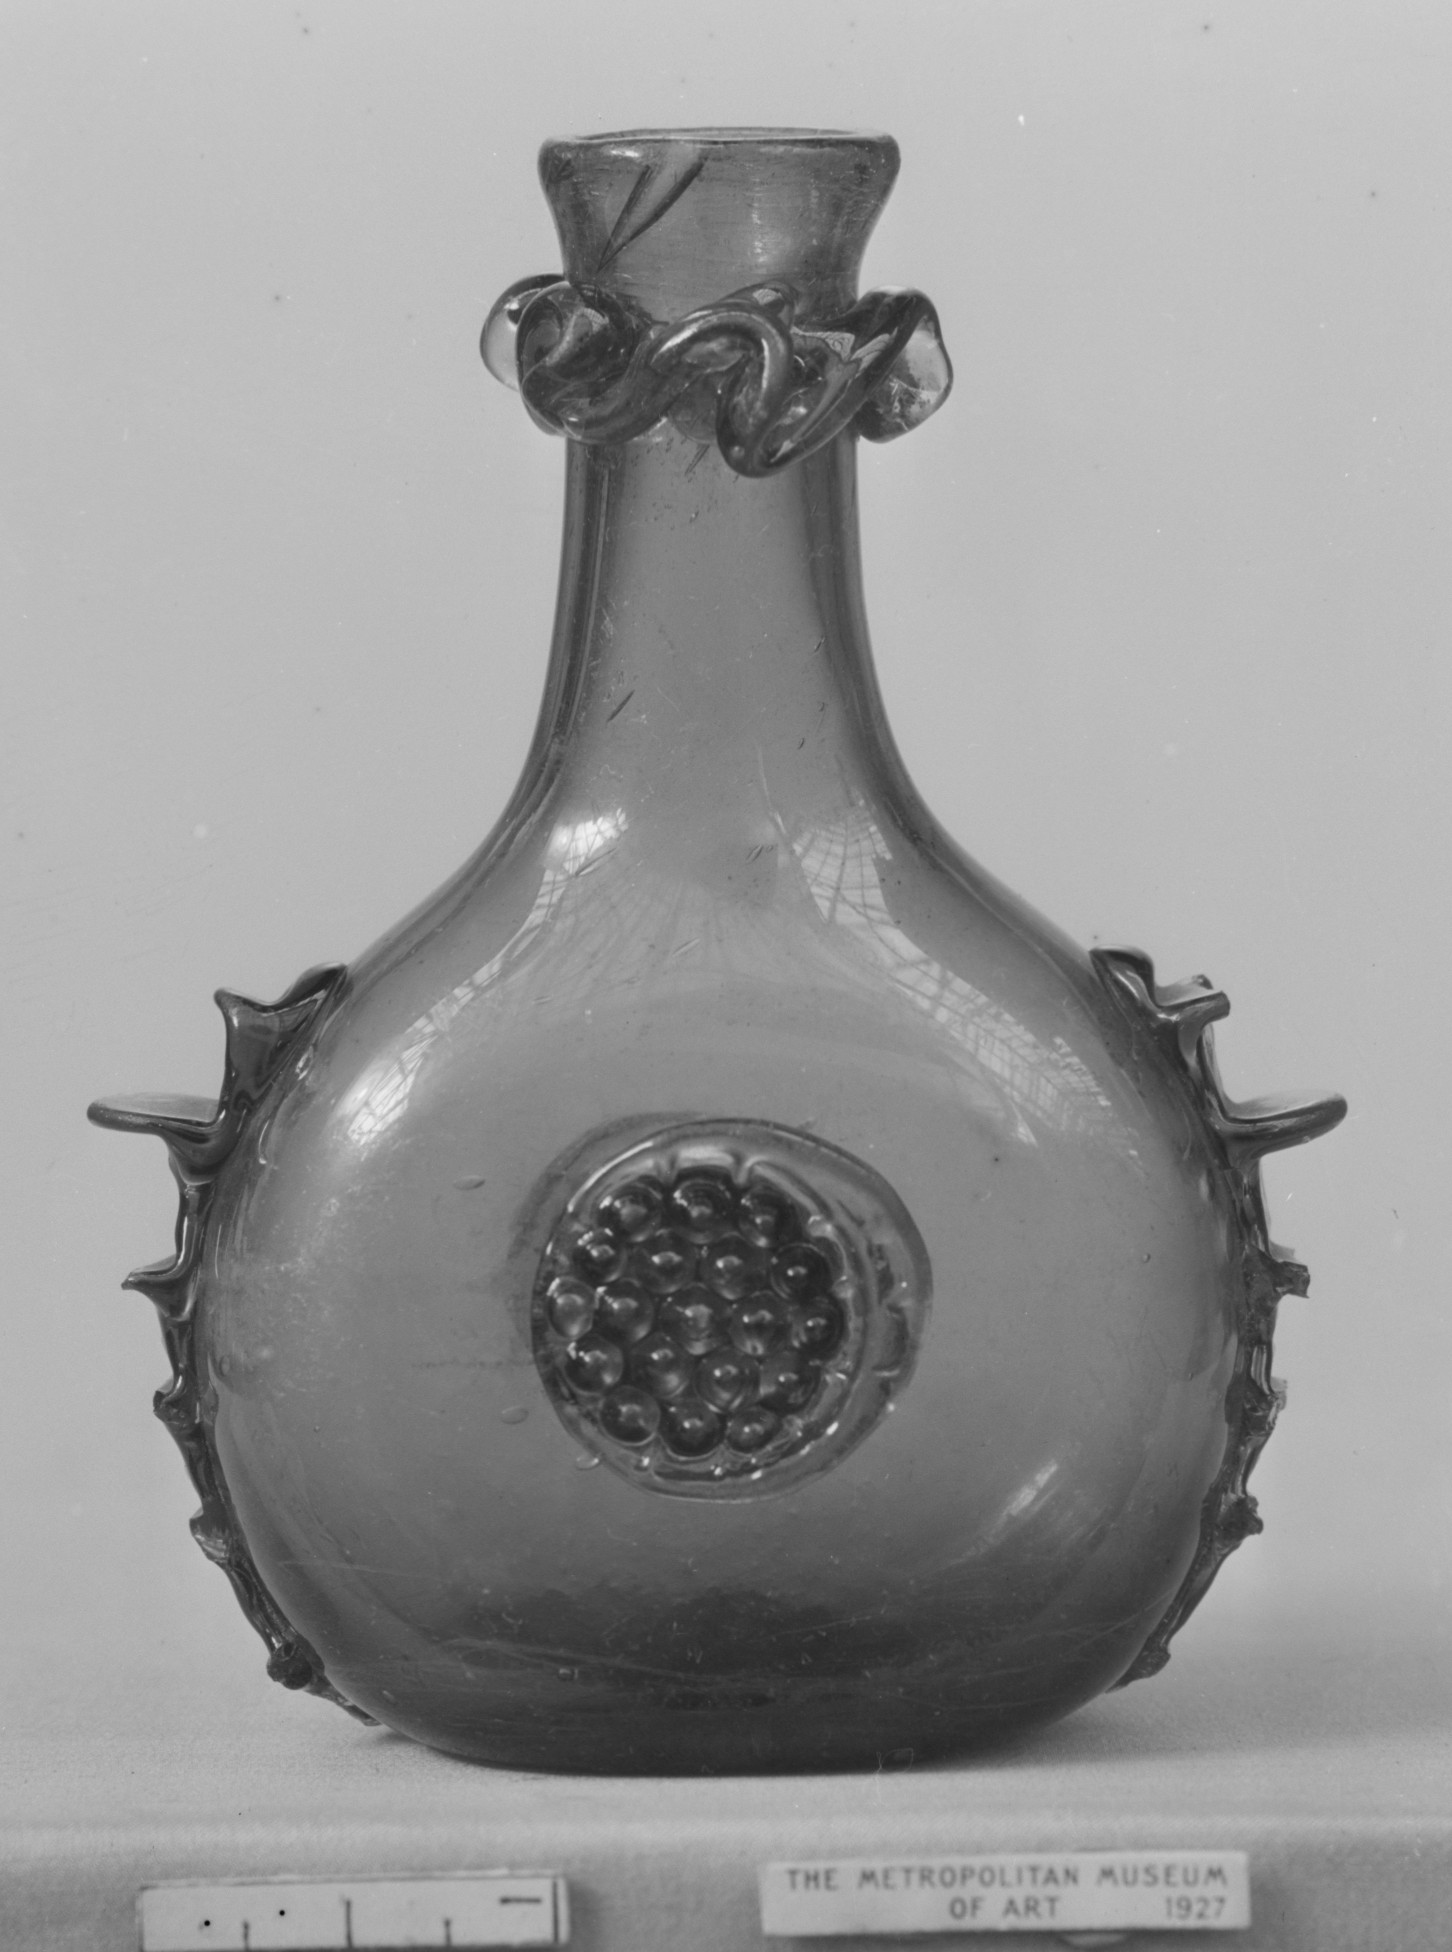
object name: bottle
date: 1501-1700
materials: glass